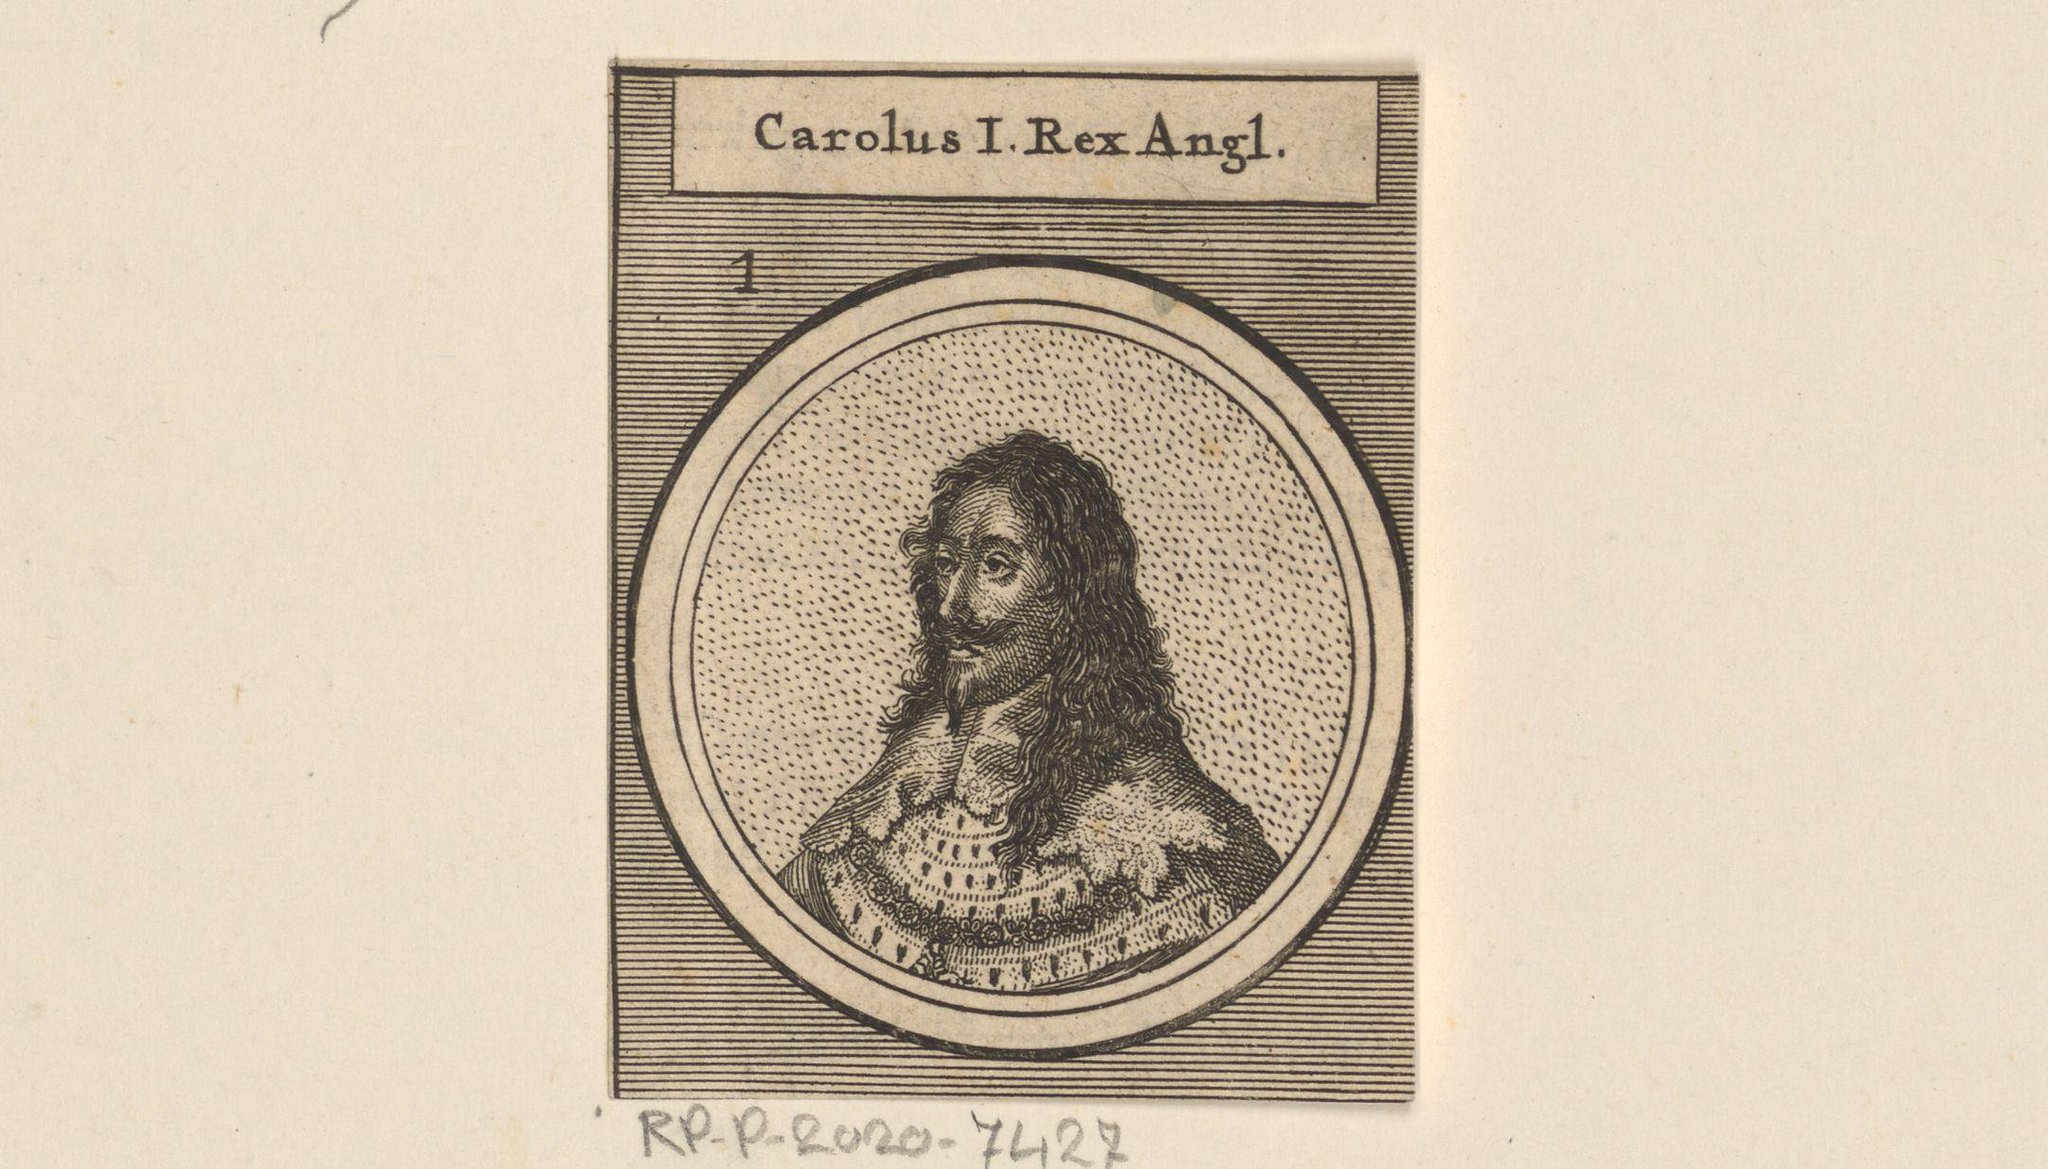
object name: print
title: Portret van Karel I, koning van Engeland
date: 1660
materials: paper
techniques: engraving, etching, letterpress printing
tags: london, karel i (koning van engeland), historical persons, king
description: Prent mogelijk uit: Gottfried, Johan Ludwig en Simon de Vries. Historische kronyck: vervattende een nauwkeurige en volkomene beschrijvingh der aldergedenck waerdiste geschiedenissen des weerelds (...). Leiden: weduwe Joannes Brouwer en Jacobus van Meurs, 1660, dl. 2. Prent ook gebruikt in latere edities. De prent maakt onderdeel uit van een grotere plaat met 24 portretten.